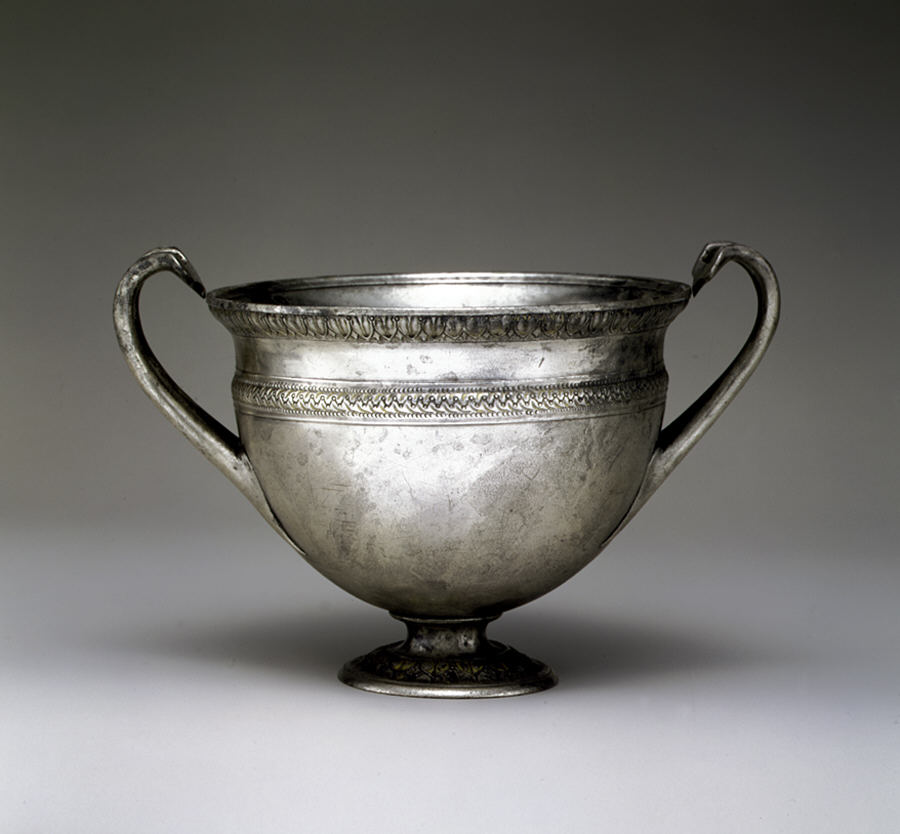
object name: skyphos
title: Silver skyphos (drinking cup)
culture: roman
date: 67-35 BCE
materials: silver